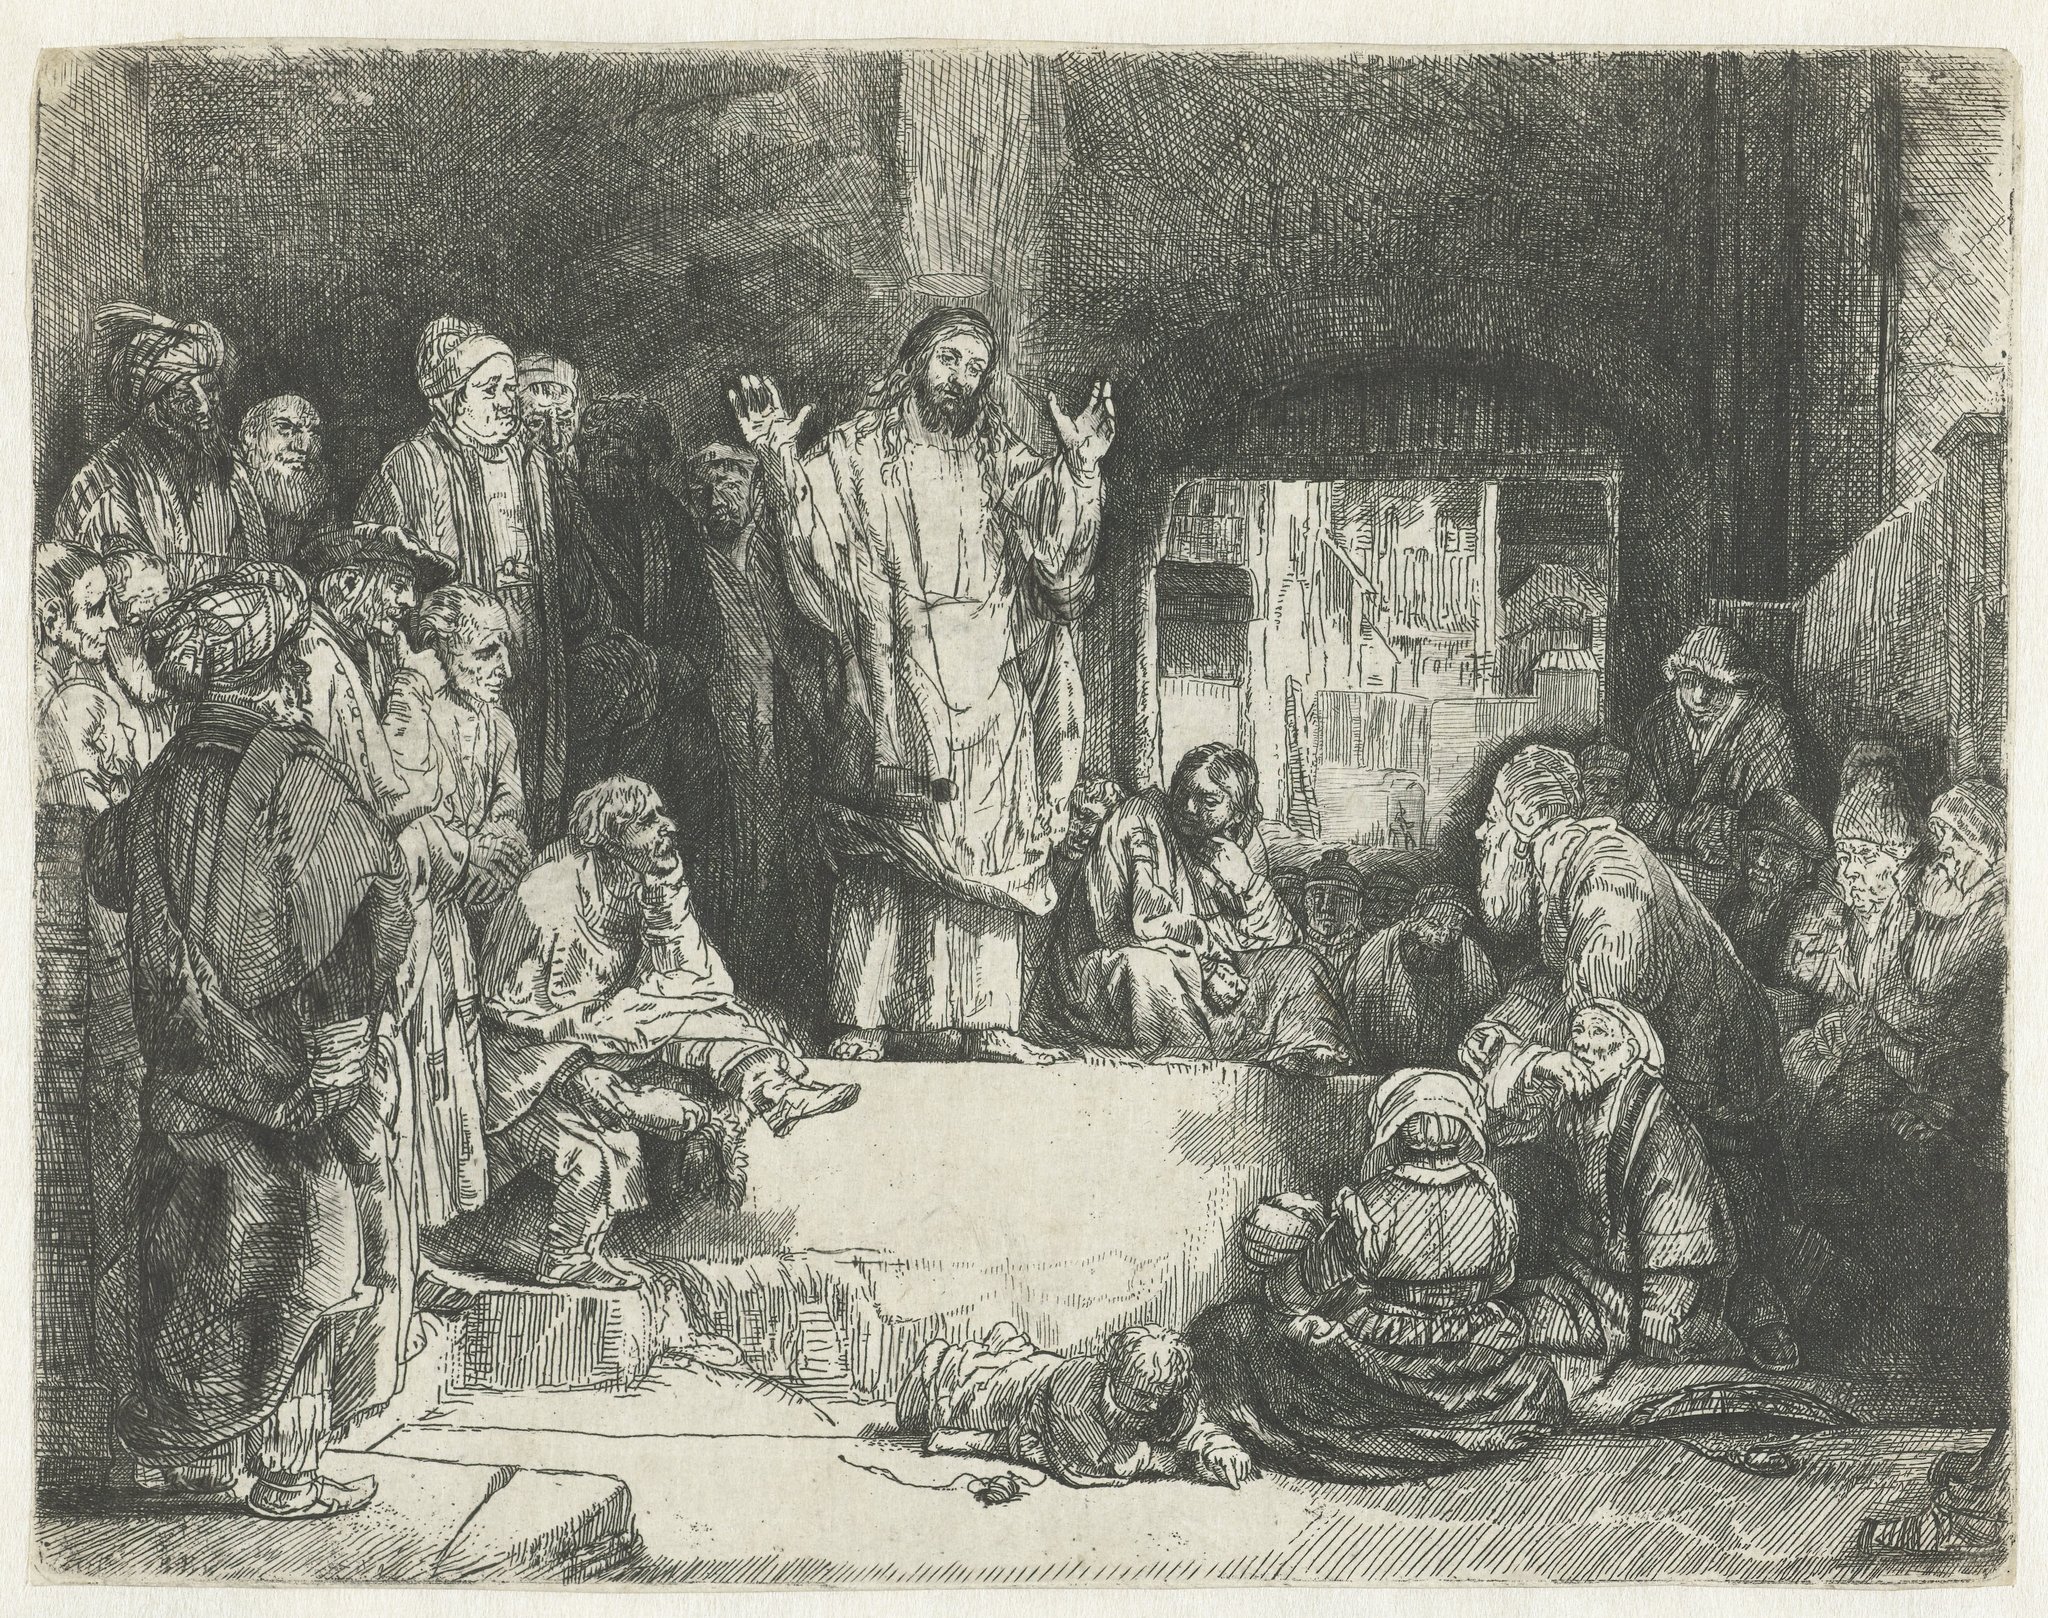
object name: print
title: Christ preaching ('La petite Tombe')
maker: james bretherton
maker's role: print maker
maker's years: 1750-1781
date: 1760-1781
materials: paper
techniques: etching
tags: christ preaching or teaching (in general)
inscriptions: collector's mark: Lugt 2228, collector's mark: Lugt 2760